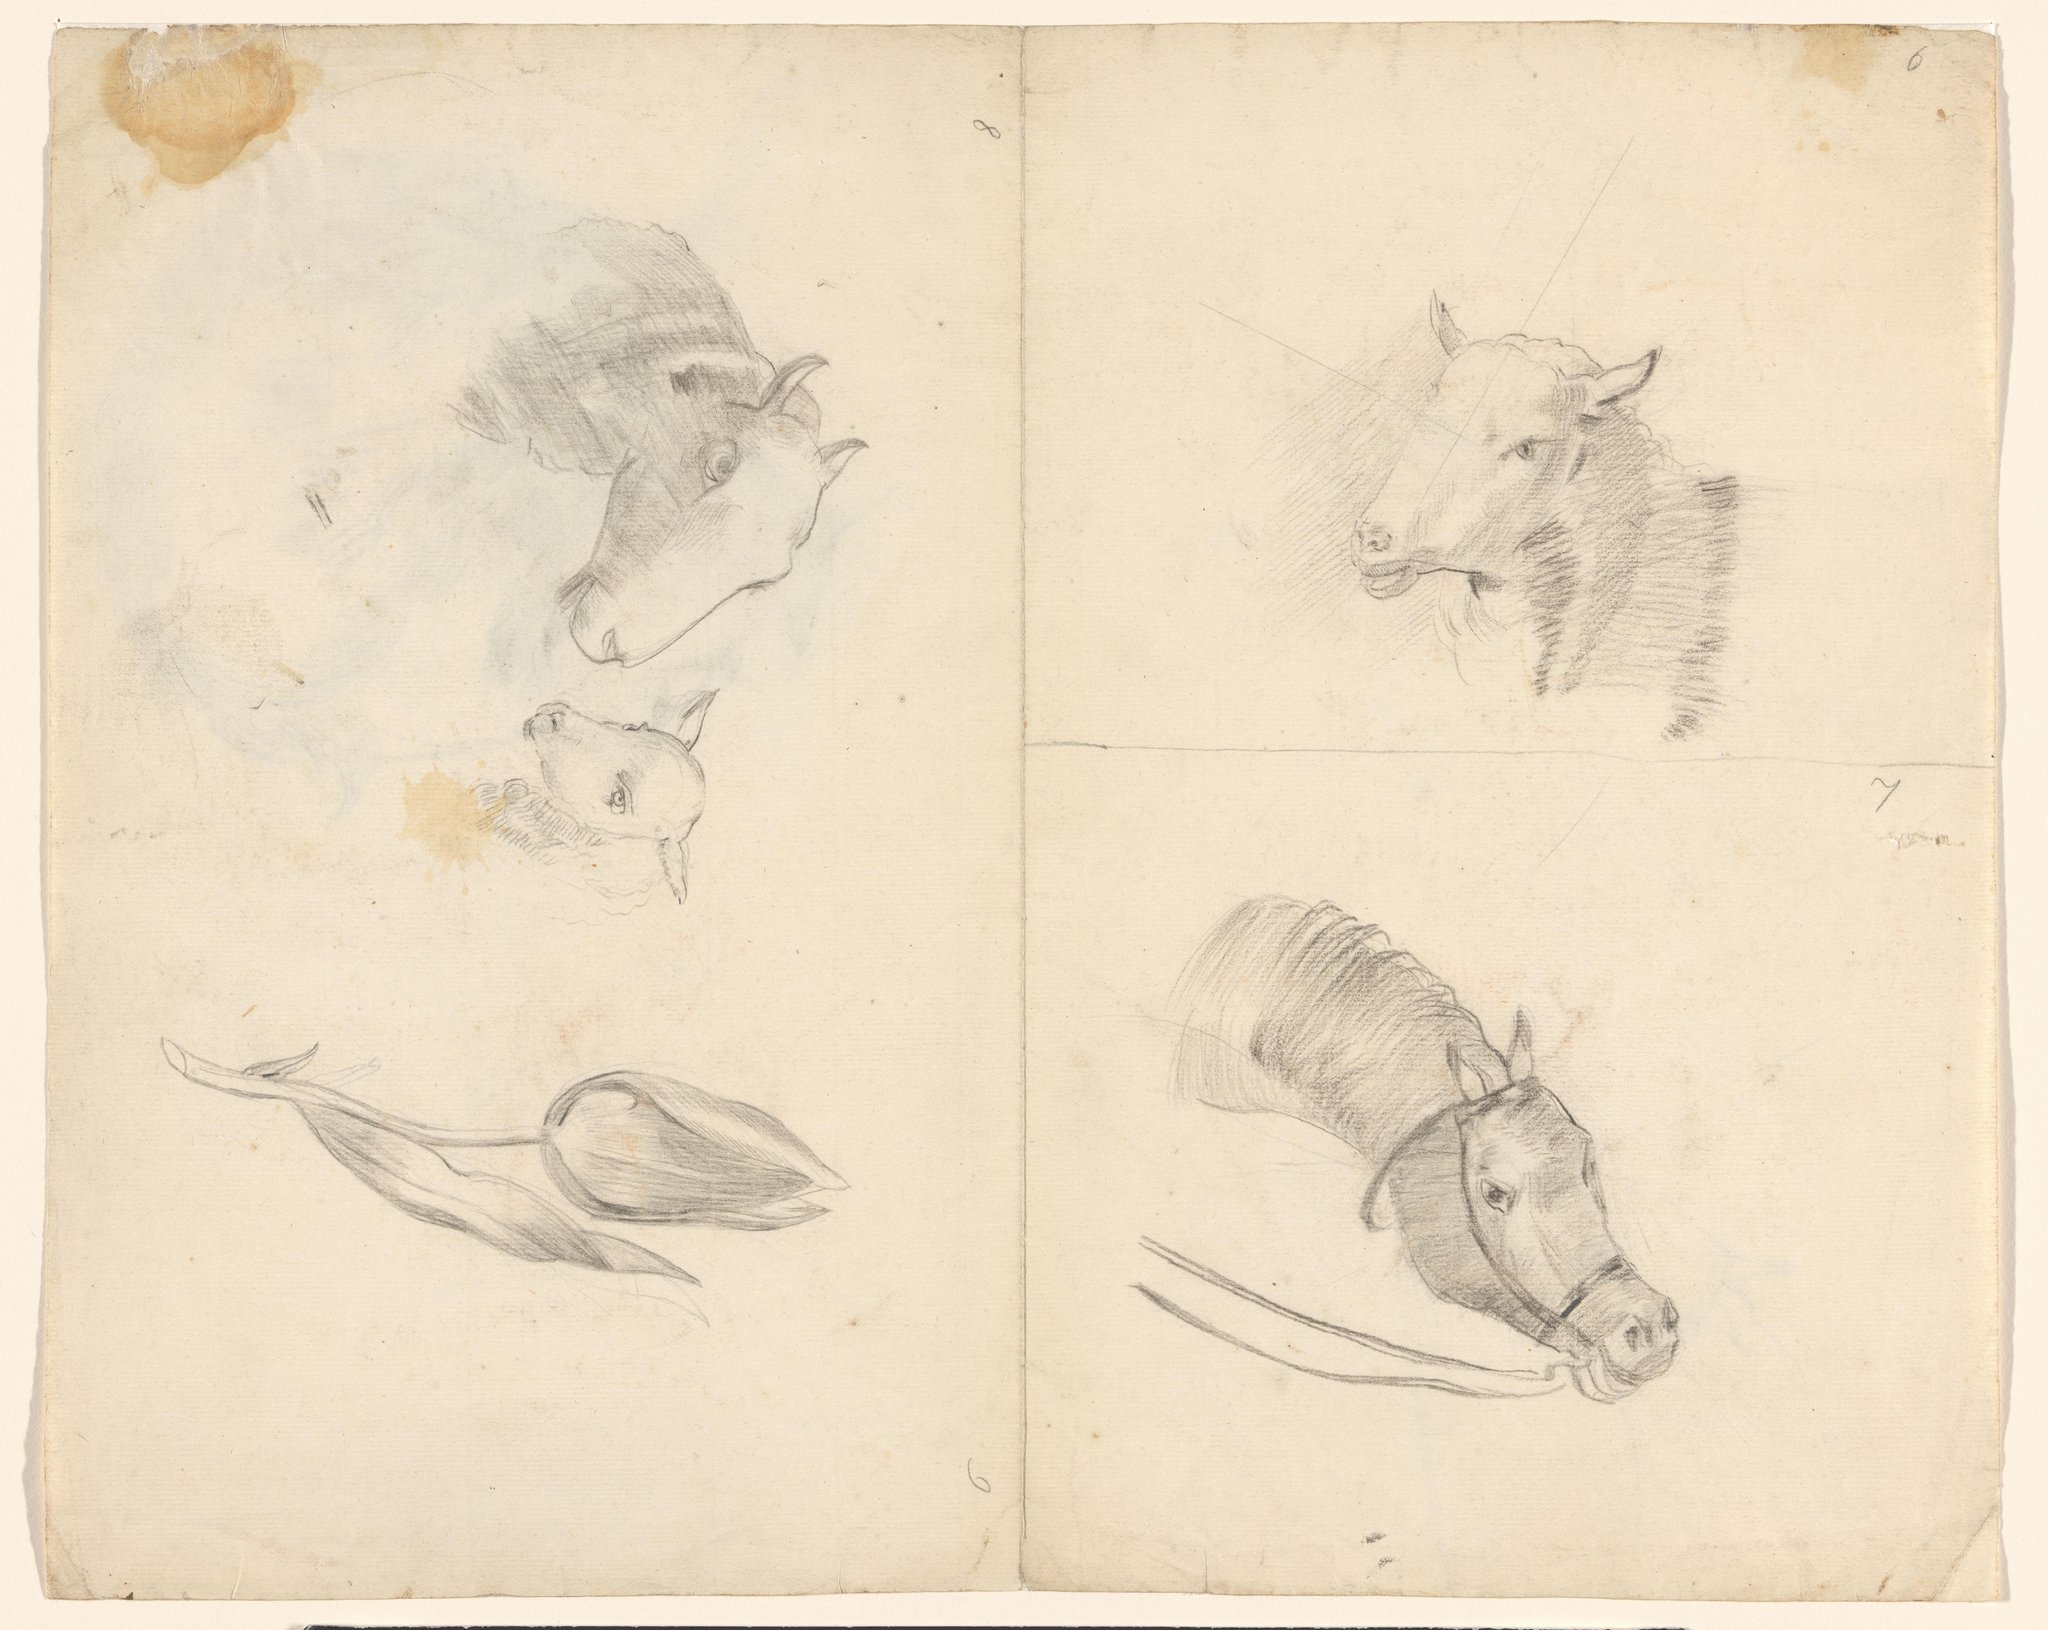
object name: drawing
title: Schetsblad met schapen, een paard en een tulp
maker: joannes carolus alberdingk thijm (jan)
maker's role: pater, schrijver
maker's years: 1847-1926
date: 1855-1870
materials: chalk, paper, pencil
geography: netherlands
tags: sheep, horse, flowers: tulip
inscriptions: inscription: ‘6 / 7 / 8’